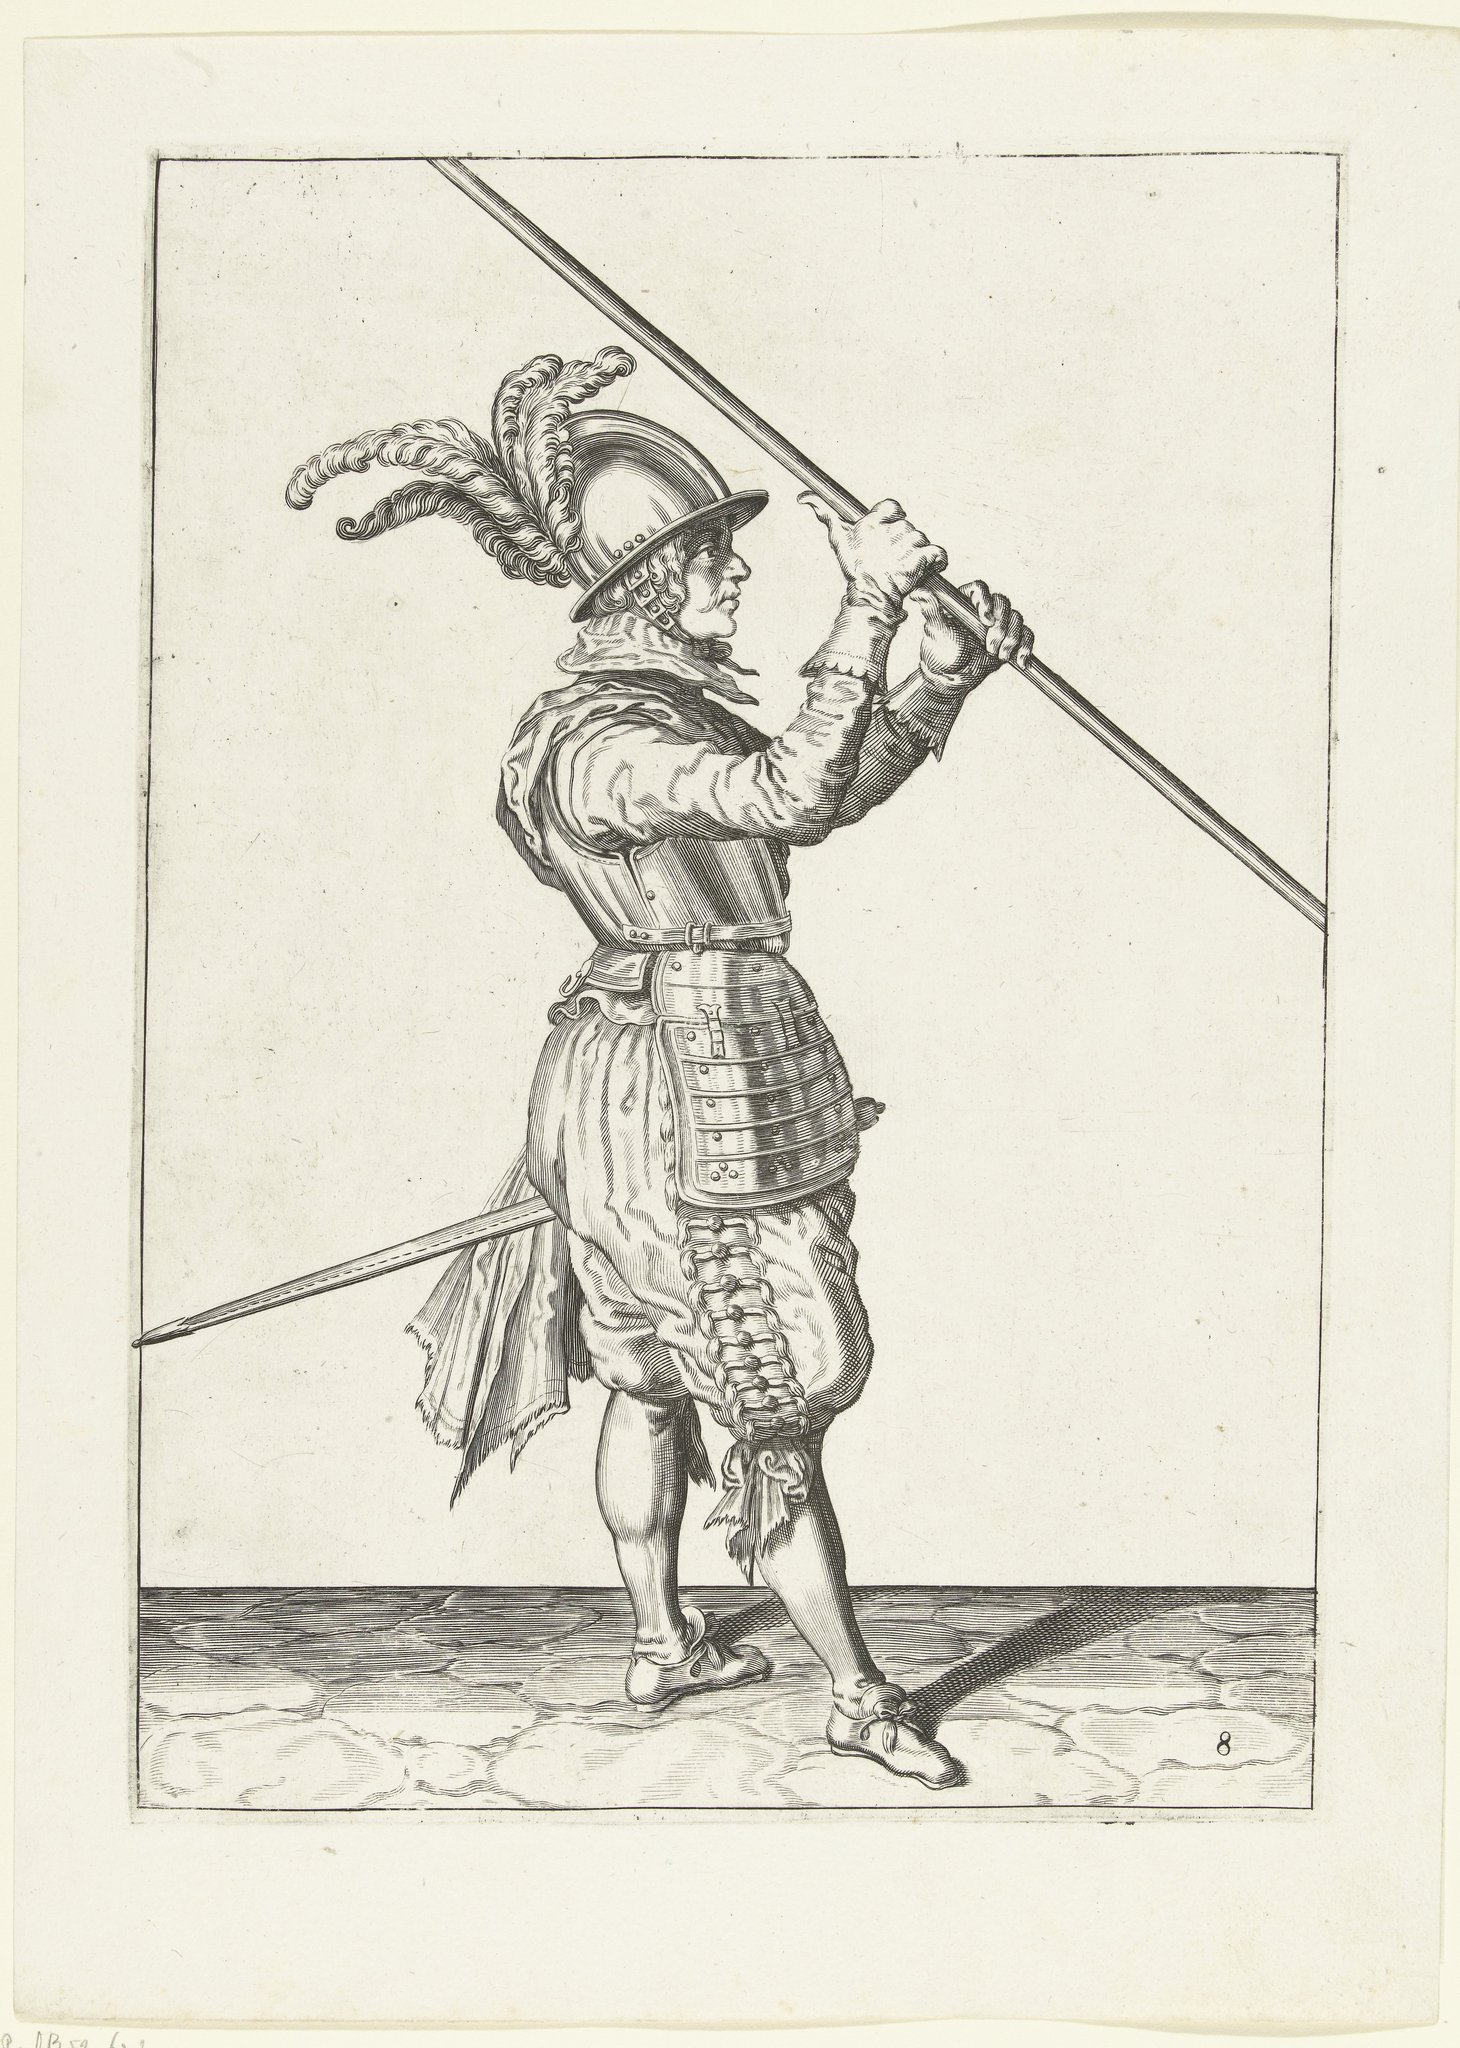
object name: print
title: Soldaat die zijn spies met beide handen dicht bij elkaar boven zijn rechterschouder draagt, de punt schuin naar de grond gericht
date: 1597-1607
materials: paper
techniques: engraving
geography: netherlands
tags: manoeuvre ~ military training, warfare; military affairs (+ mercenary troops, e.g.: lansquenets), helved weapons, polearms (for striking, hacking, thrusting): lance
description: Een soldaat, ten voeten uit, naar rechts, die een spies (lans) boven zijn rechterschouder draagt, de punt schuin naar de grond gericht. Zijn handen dicht bij elkaar om de spies. Dit is de eerste handeling voor het opheffen van de spies naar de schouder en het horizontaal dragen ervan. Deze prent is onderdeel van de reeks van 32 genummerde prenten van spiesdragers uit de Wapenhandelinghe.